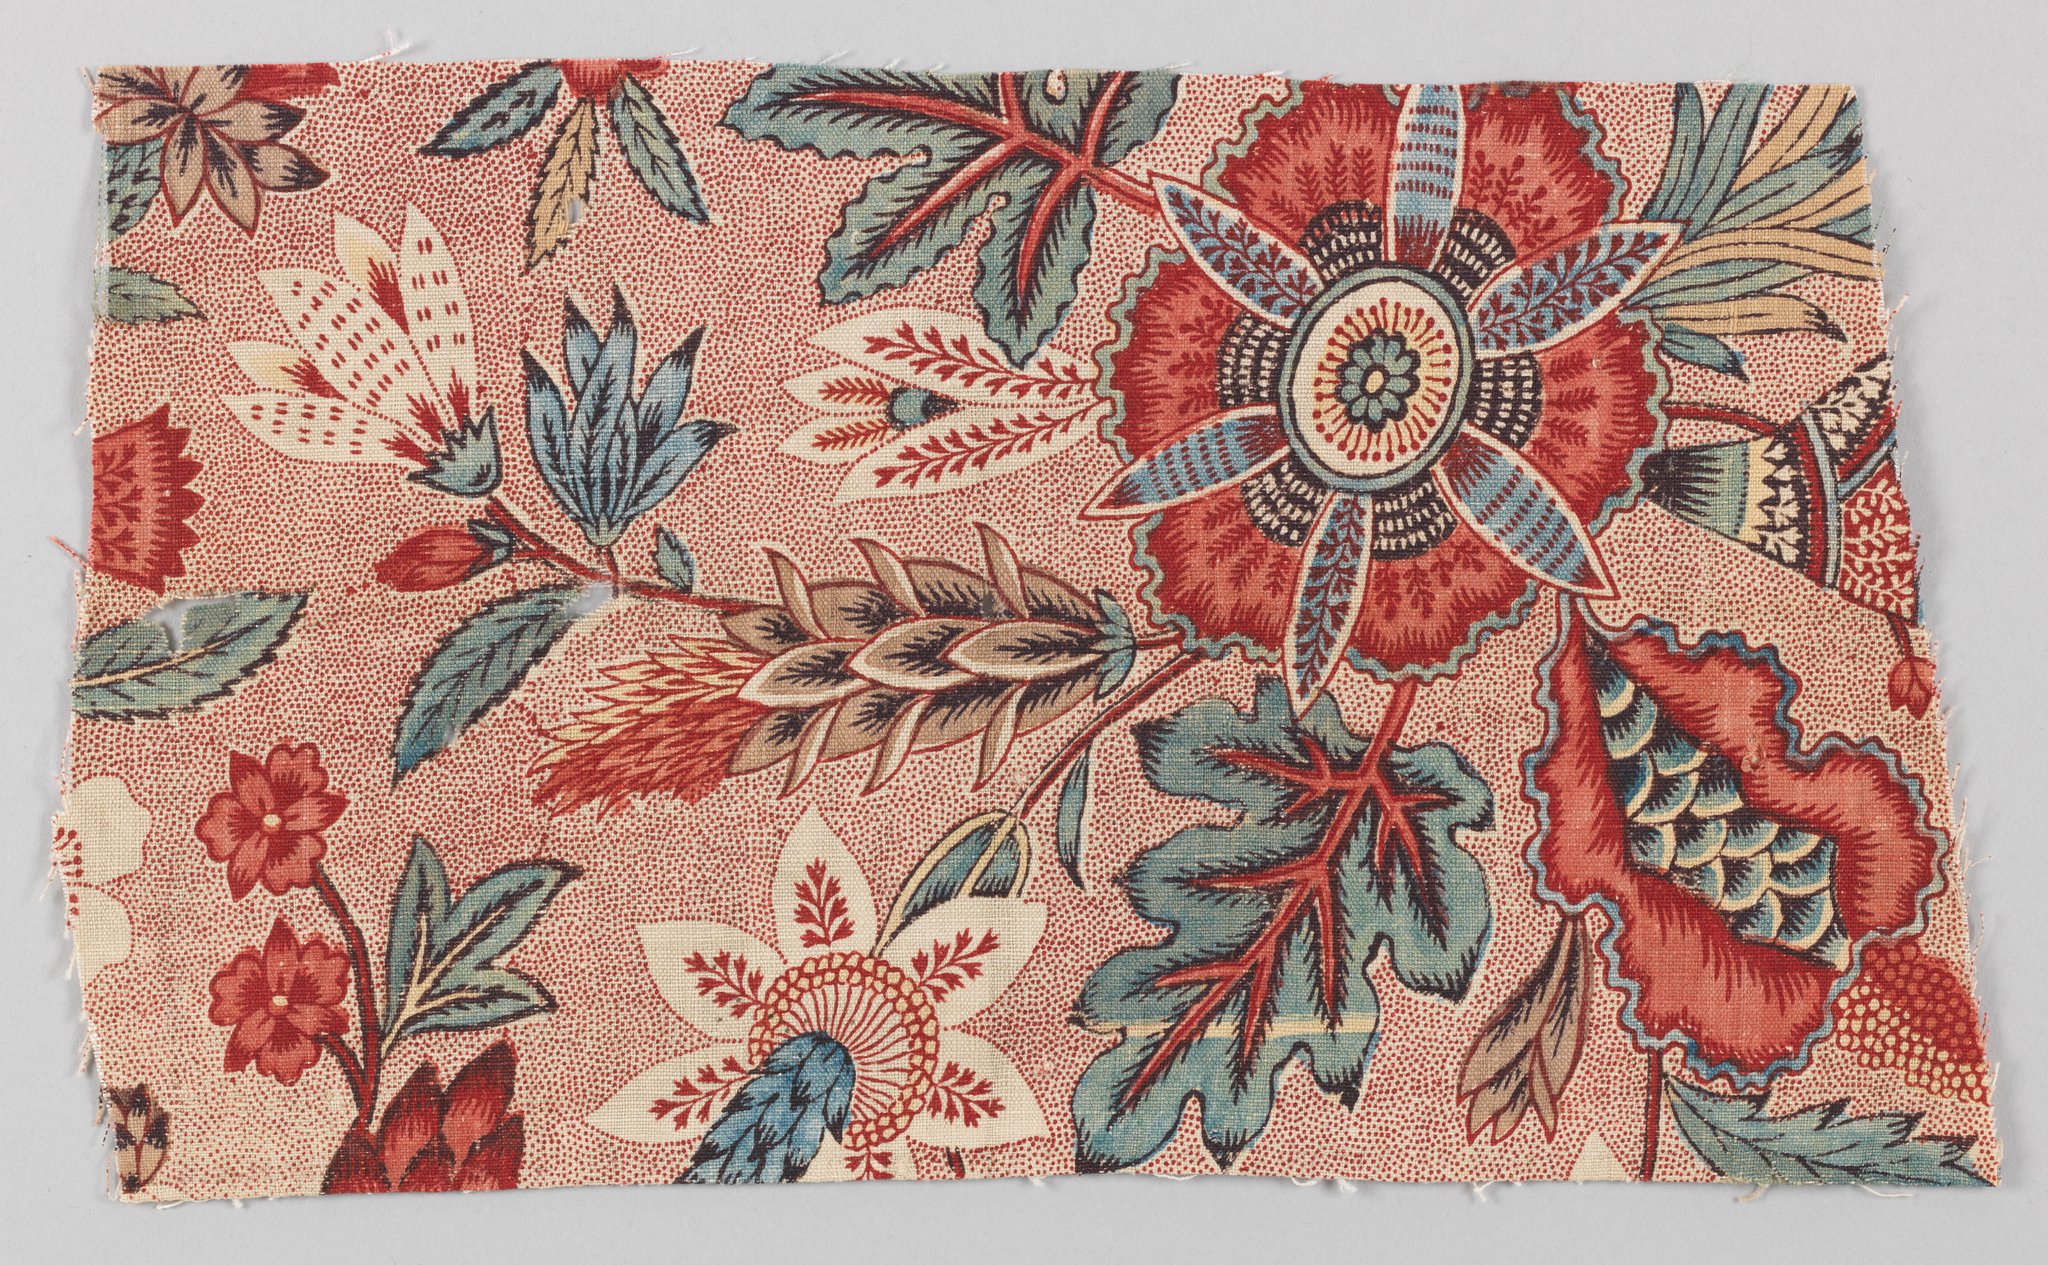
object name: fragment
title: Fragment of printed cotton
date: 1767-1800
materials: cotton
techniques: printing